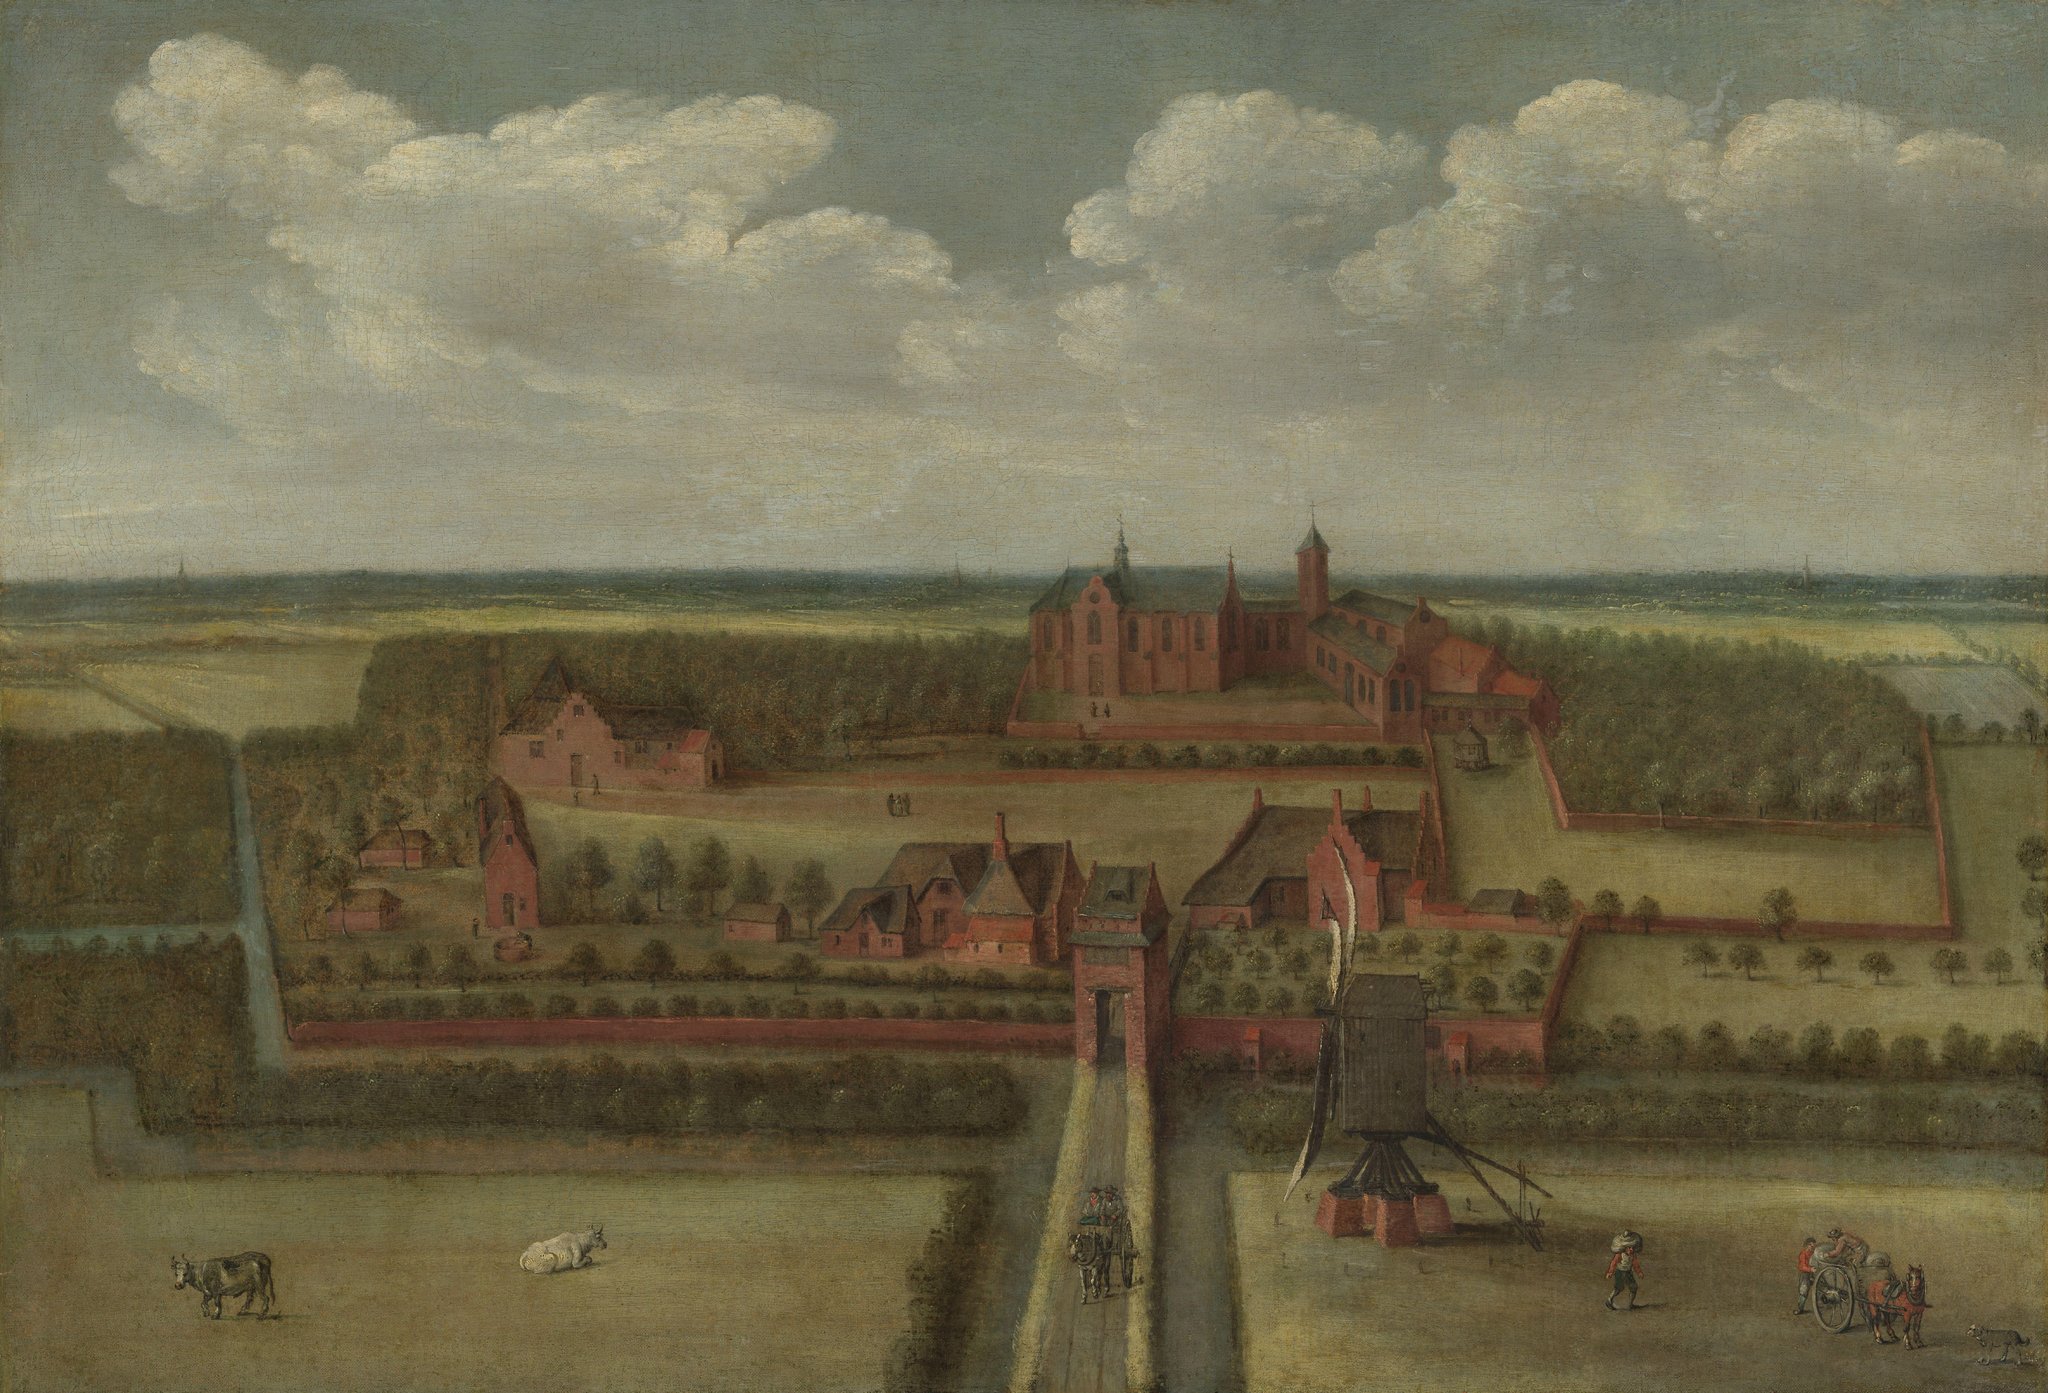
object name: painting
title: The Abbey of Leeuwenhorst in Rijnland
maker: Anonymous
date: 1641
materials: canvas, oil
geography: northern netherlands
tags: abbey, monastery, convent ~ roman catholic church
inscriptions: date: ‘1641’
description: Gezicht op de abdij Leeuwenhorst te Noordwijk in Rijnland. Het landgoed met de abdij en bossen is omgeven door een muur. Op de voorgrond de oprit naar het klooster met enkele figuren in een wagen, links en rechts weilanden. Rechts van de poort staat een molen.